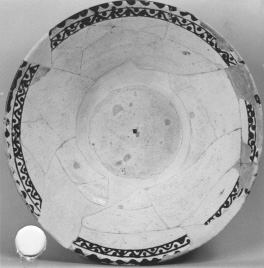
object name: bowl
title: Bowl with Black and White Geometric Decoration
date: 801-900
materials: earthenware, glaze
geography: iran